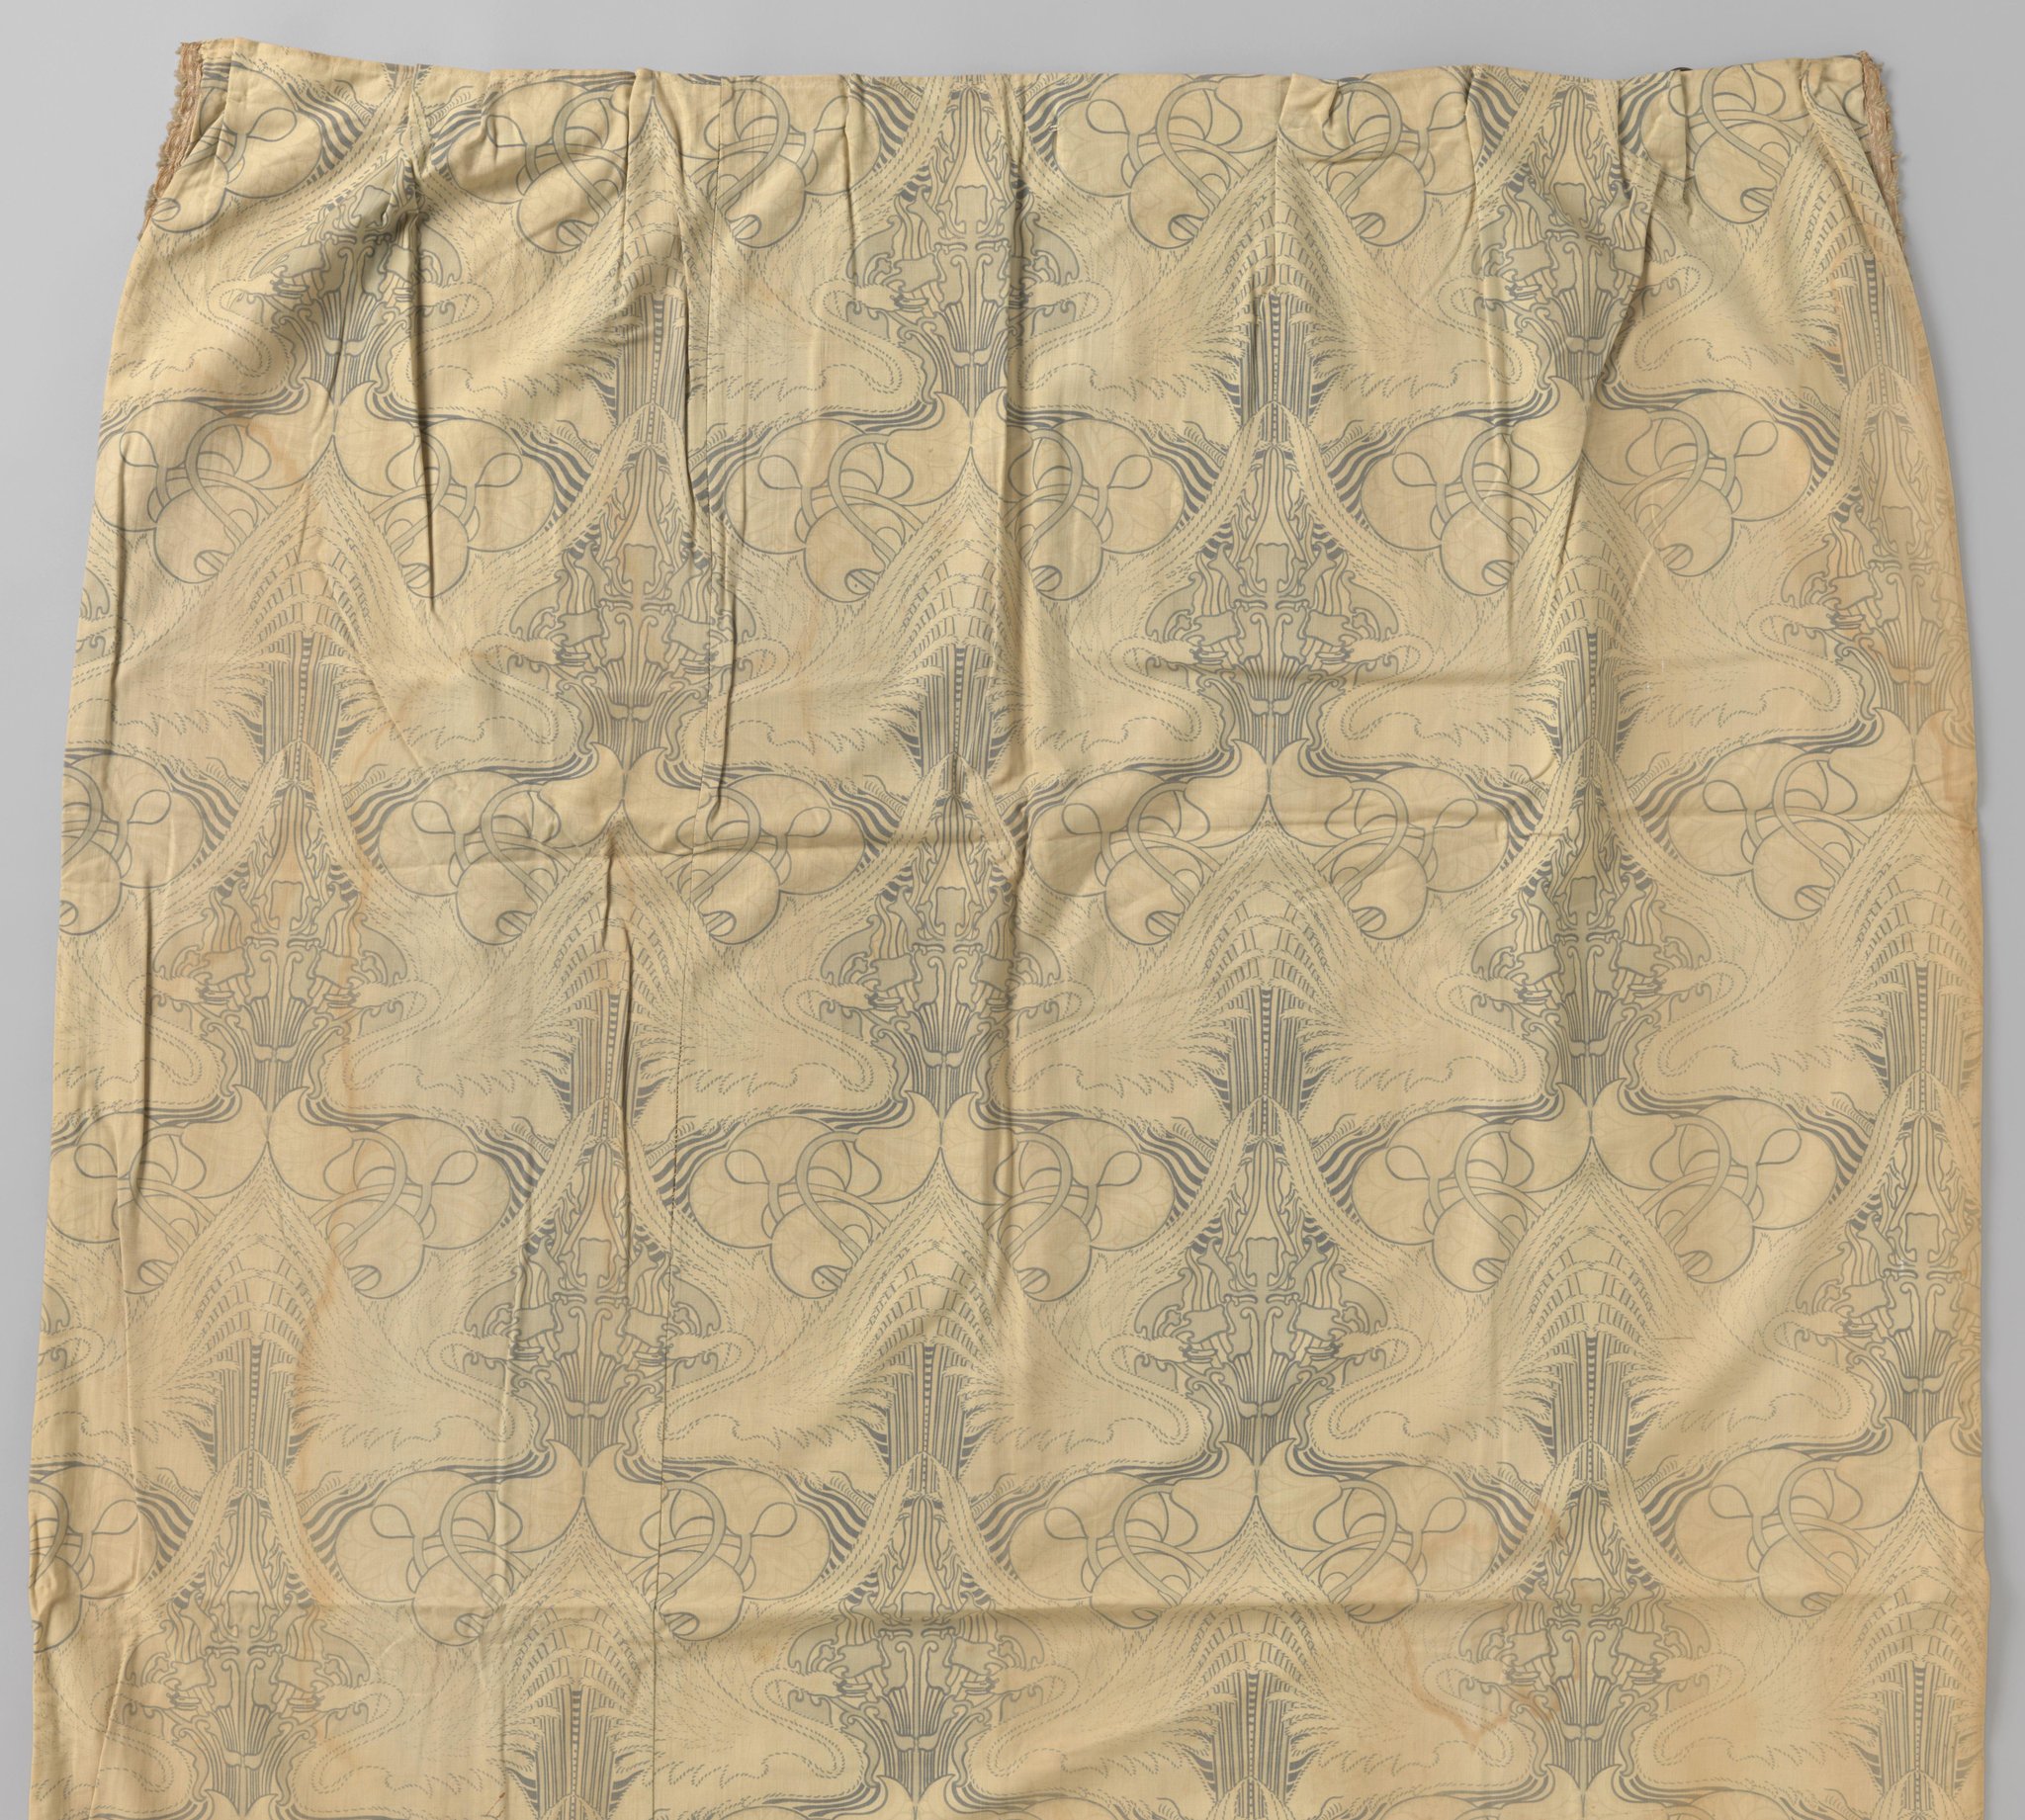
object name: overgordijn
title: Overgordijn van bedrukte cretonne met zwanen en lissen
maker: michiel duco crop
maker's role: designer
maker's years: 1862-1901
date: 1900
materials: linen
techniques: printing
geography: helmond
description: Overgordijn van bedrukte cretonne met zwanen en lissen. Gevoerd en voorzien van passement met metalen ringen.